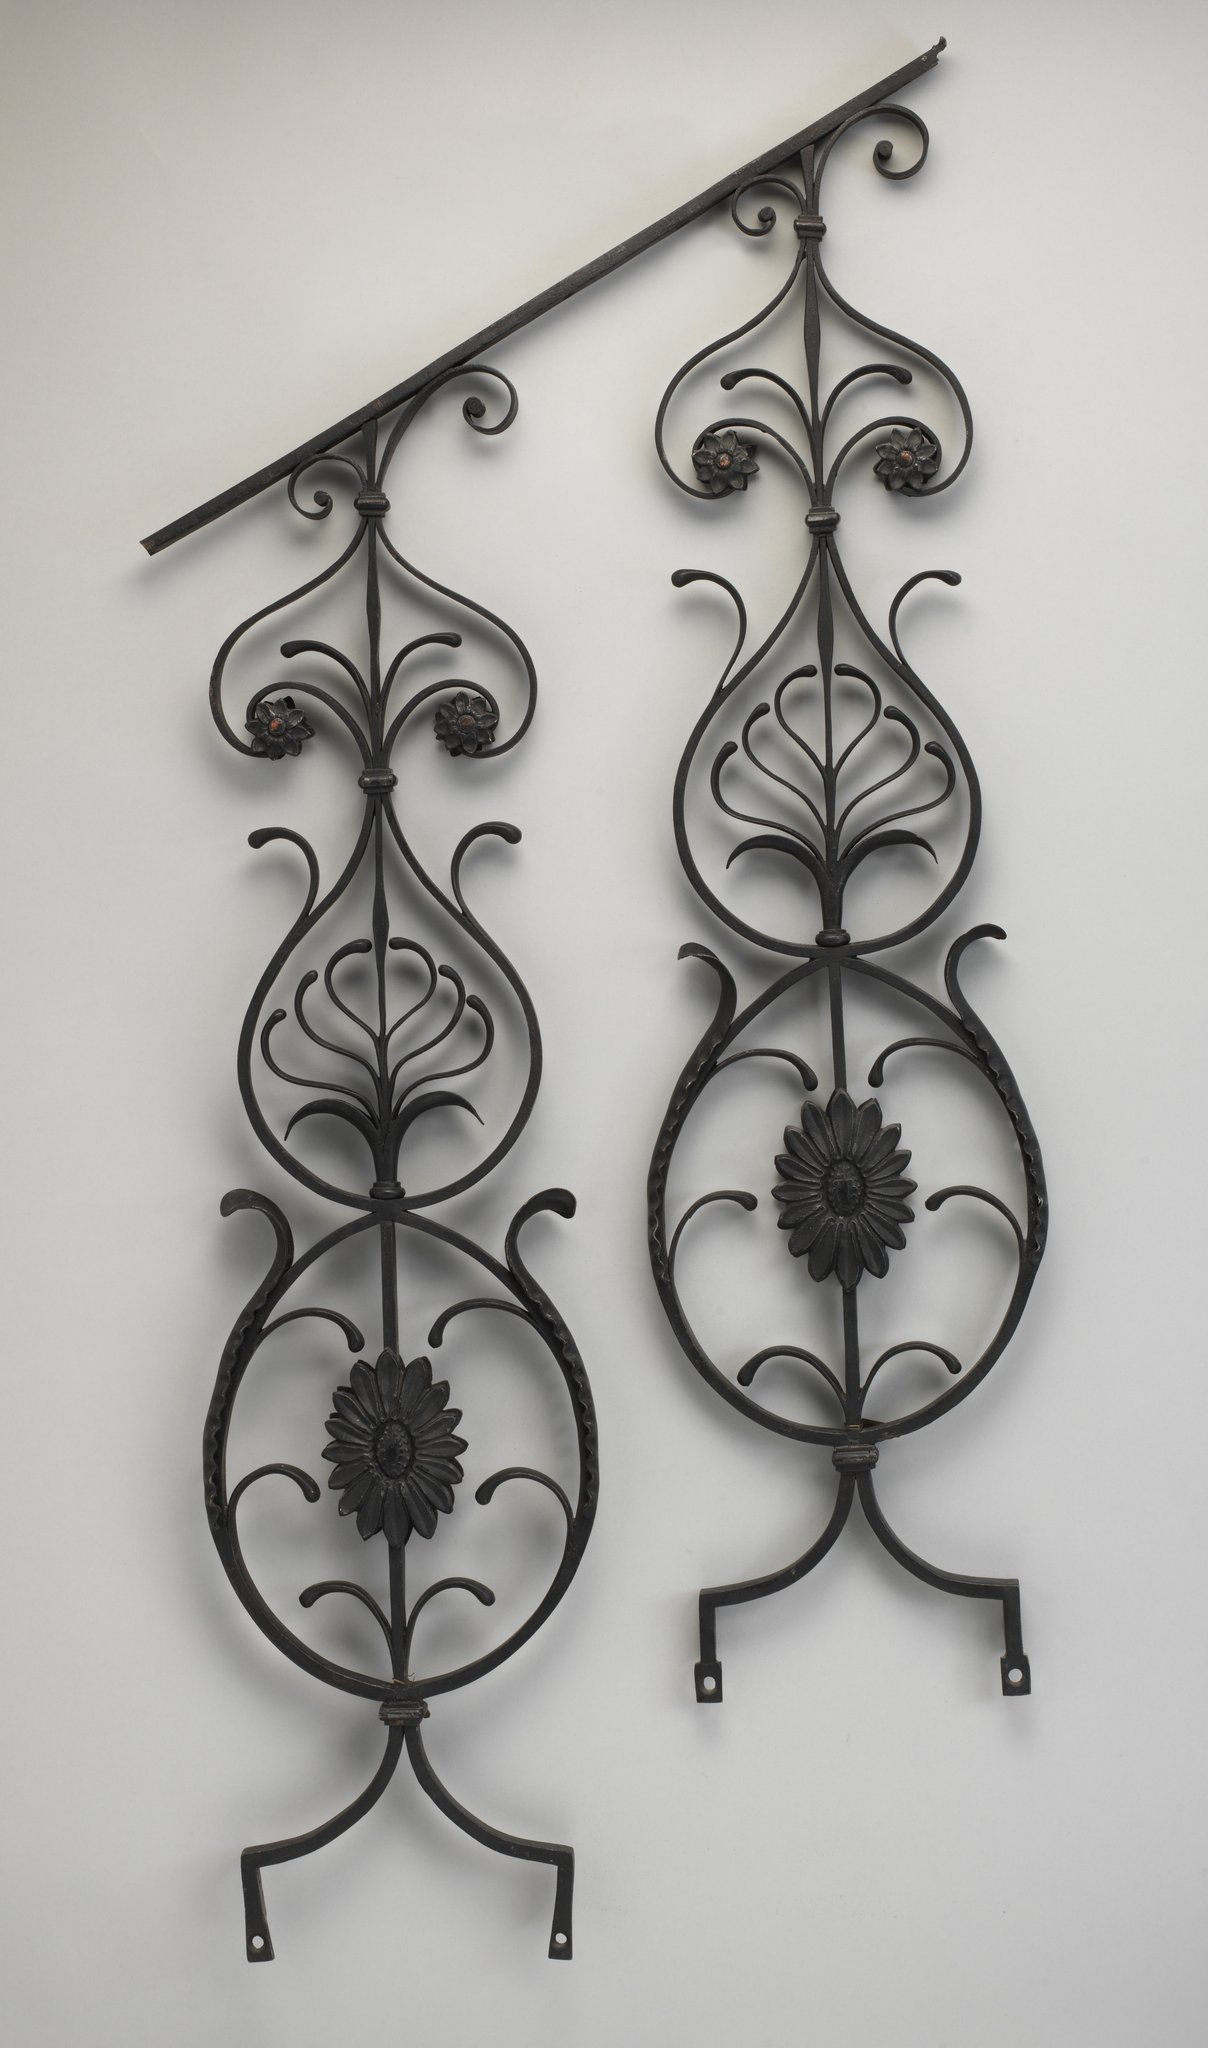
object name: baluster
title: Pair of iron balusters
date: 1770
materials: lead, iron